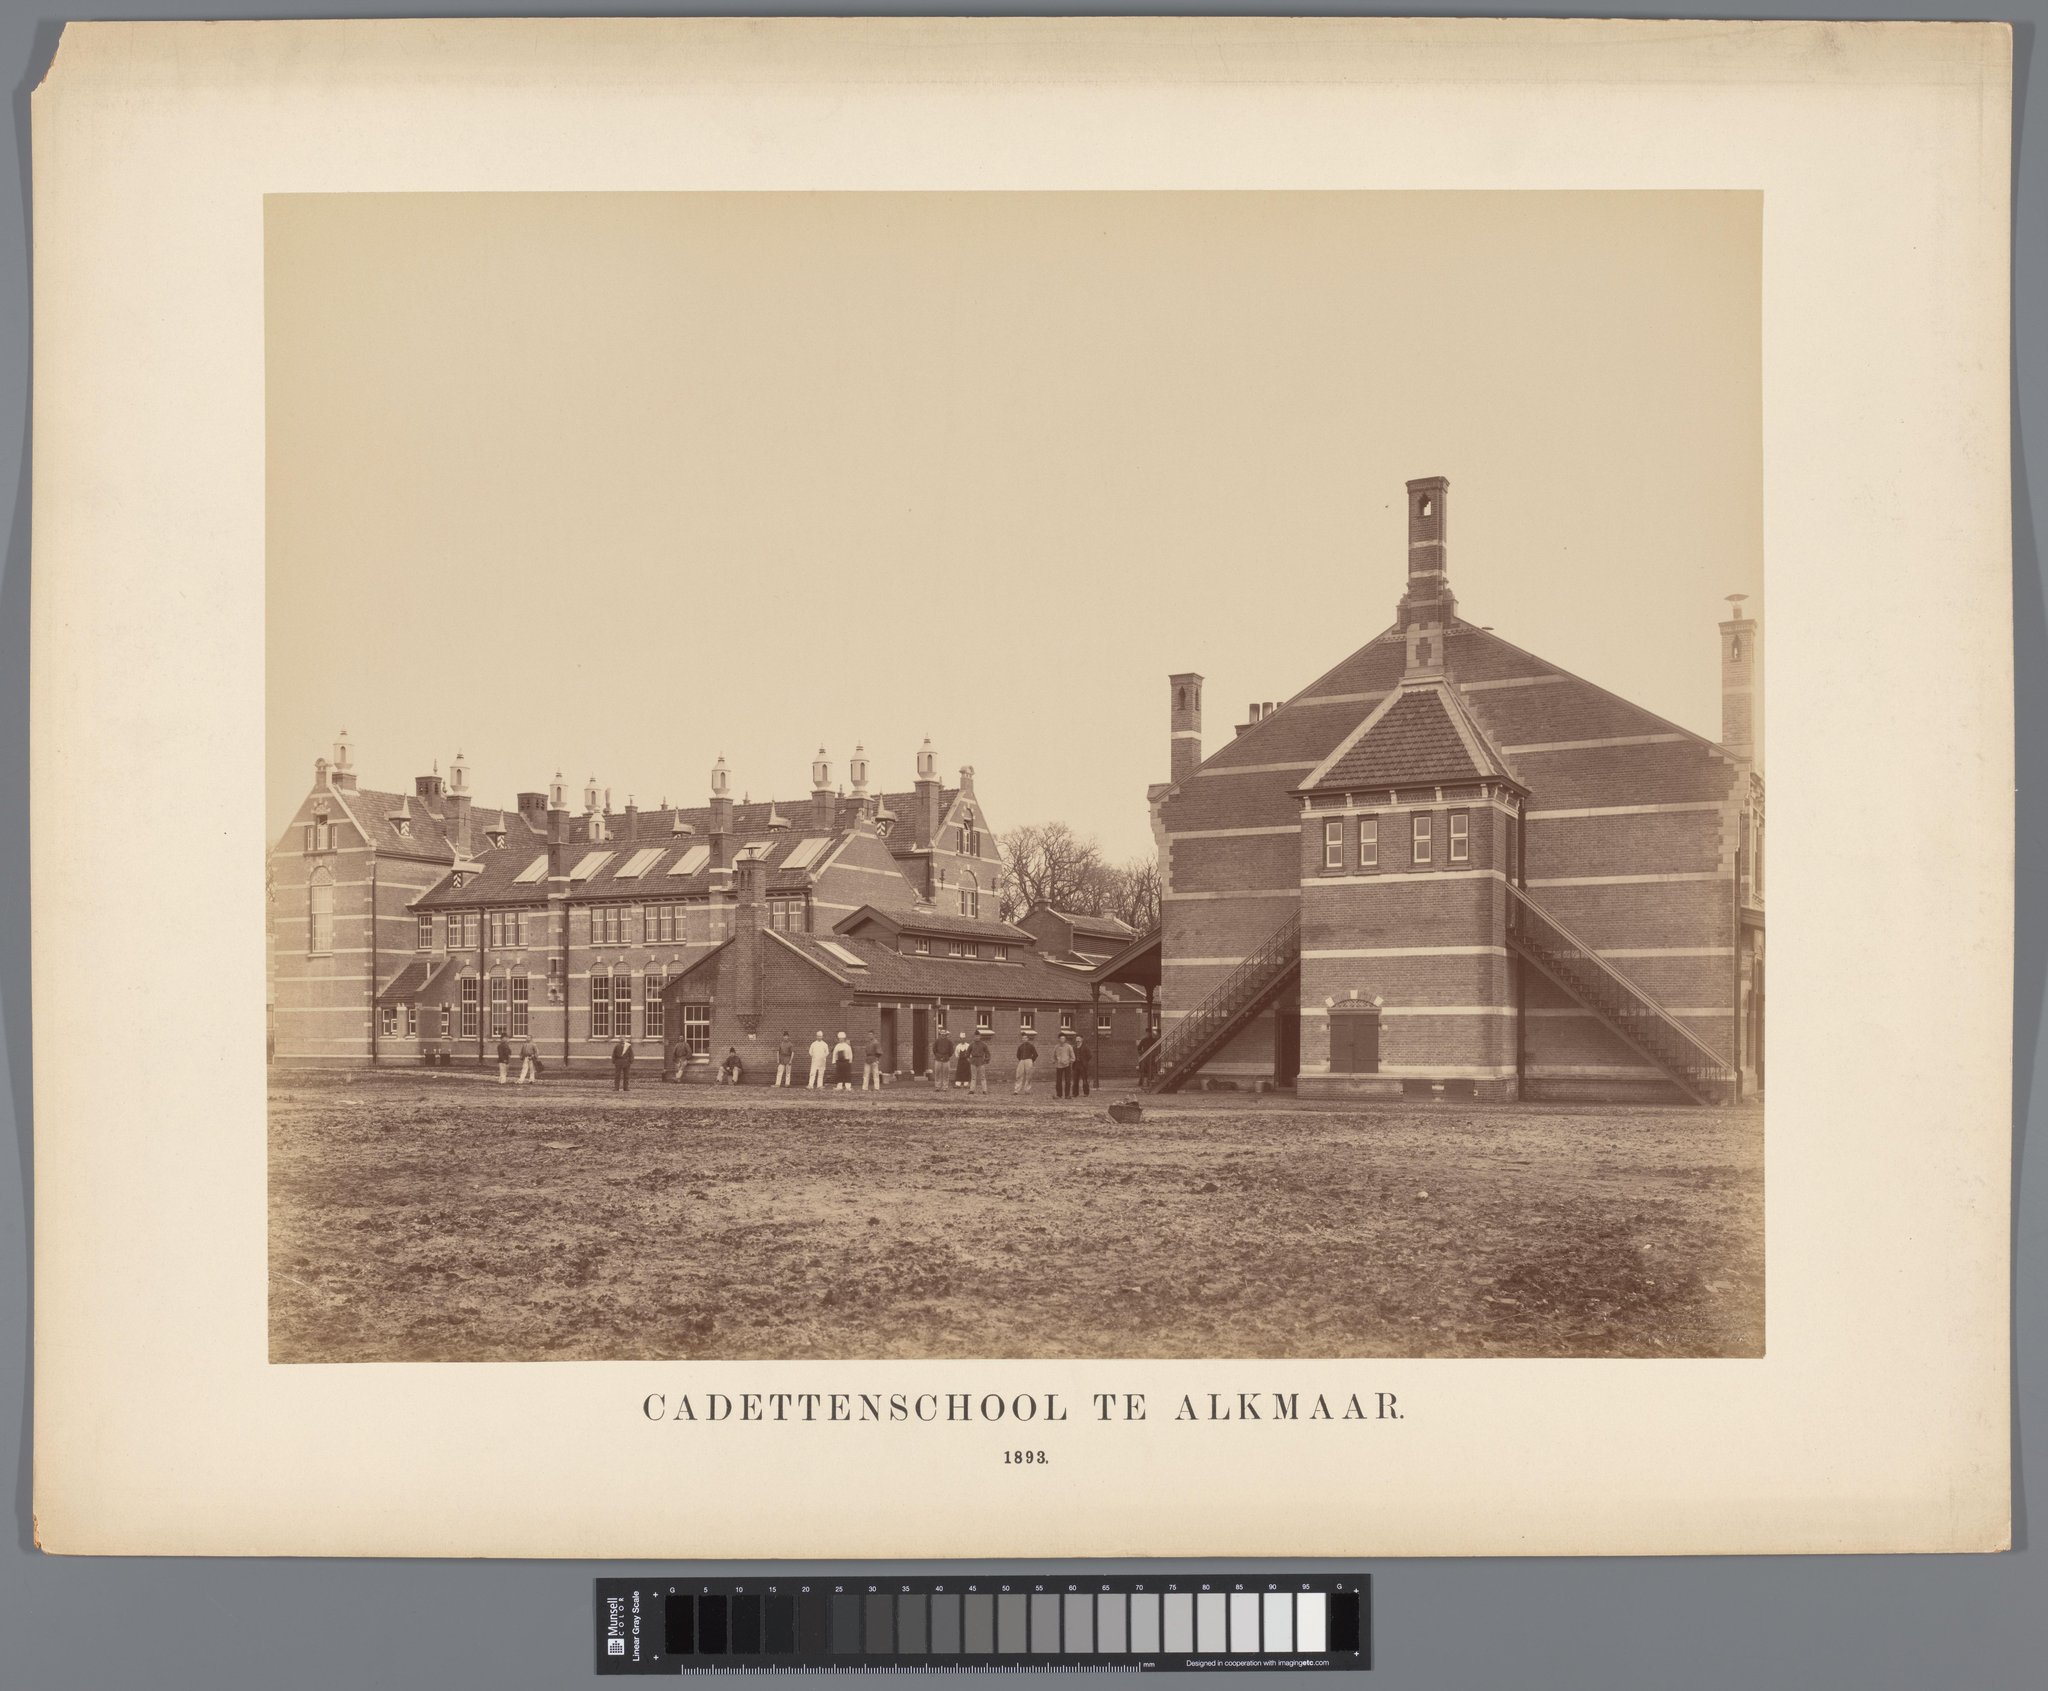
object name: photograph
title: Cadettenschool te Alkmaar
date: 1893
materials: cardboard, paper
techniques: photography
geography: alkmaar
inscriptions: date